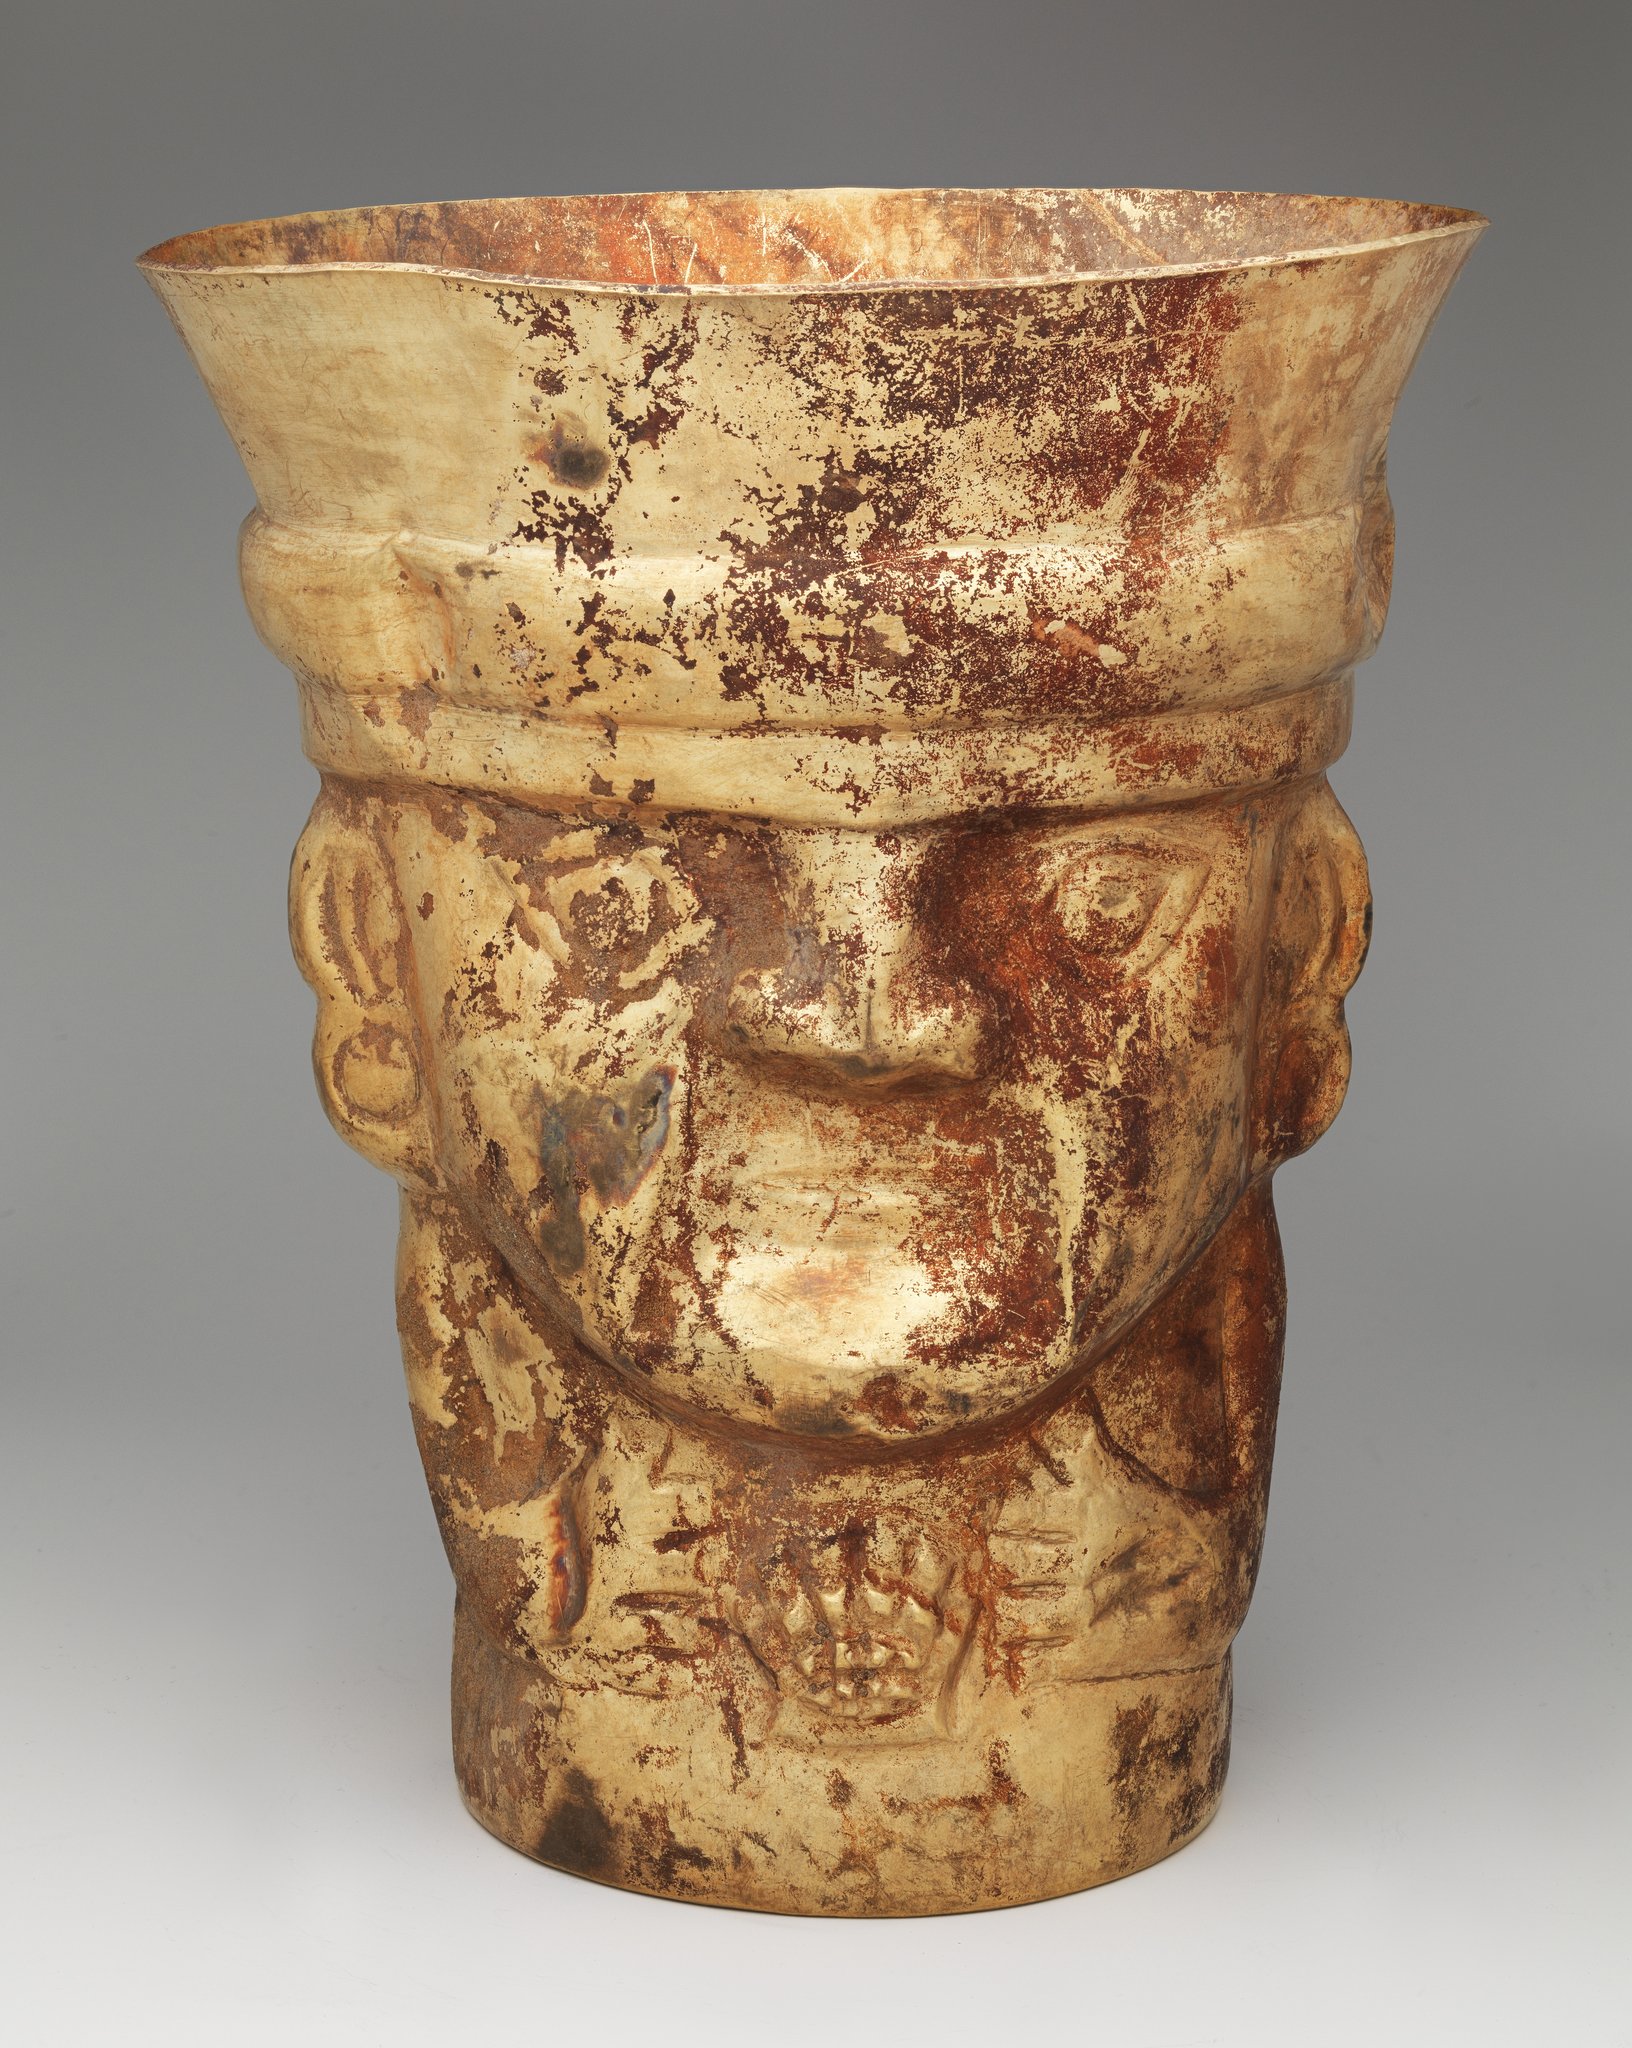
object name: beaker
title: Beaker with figure and Spondylus shell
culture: lambayeque, sicán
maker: lambayeque (sicán) artist(s)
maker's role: artist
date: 900-1100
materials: gold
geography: peru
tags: faces